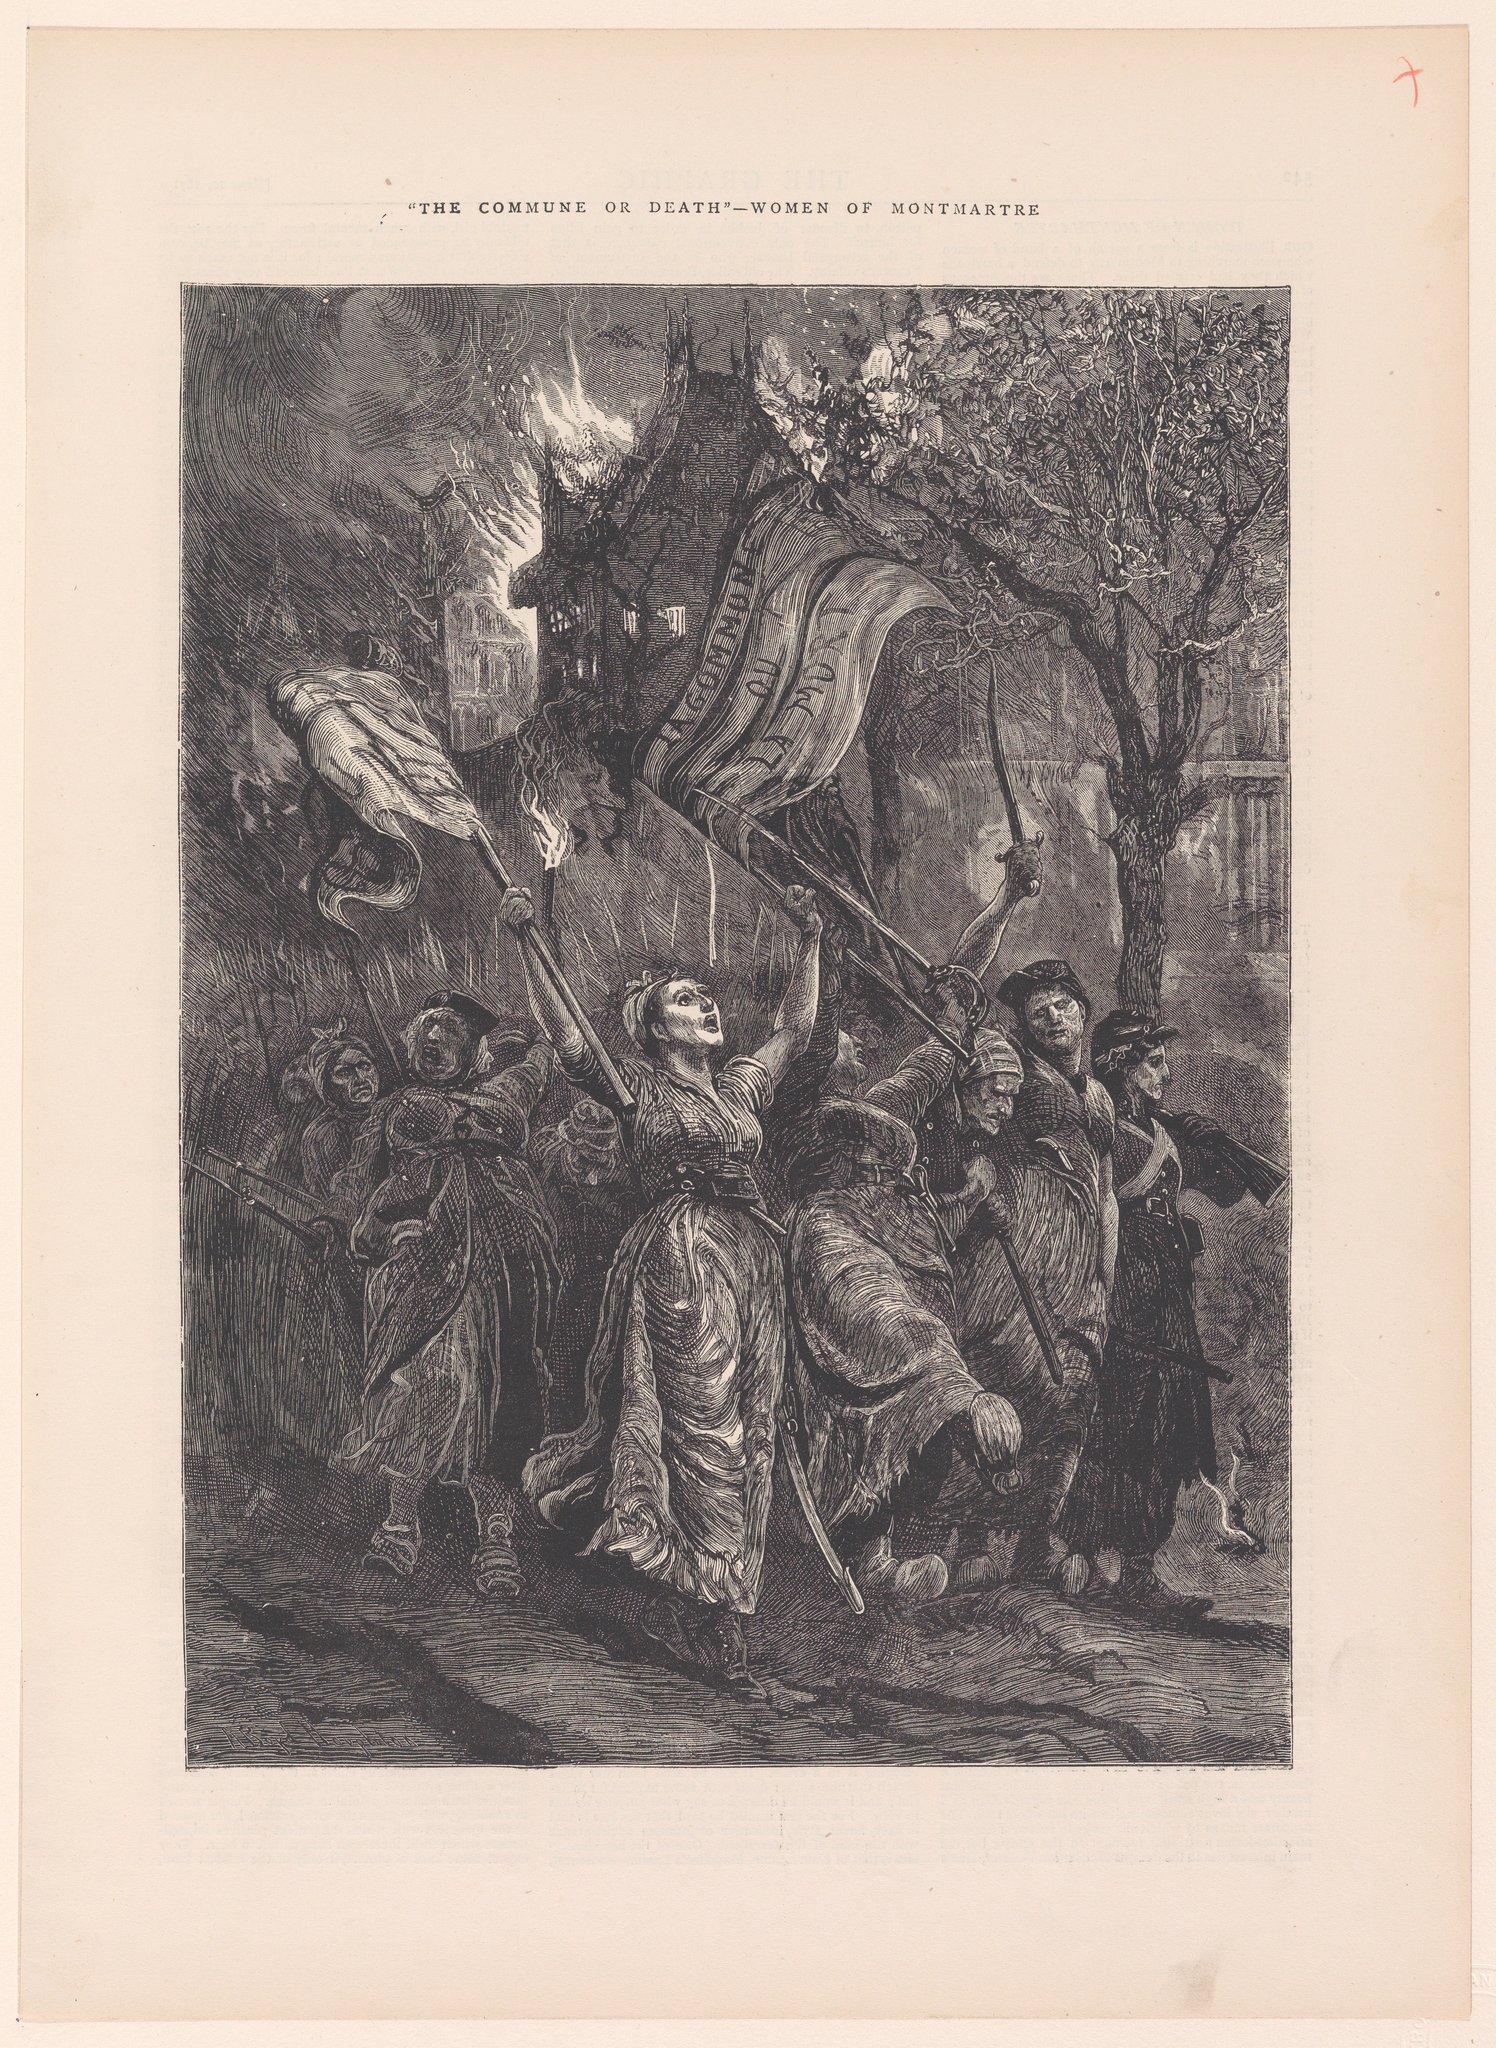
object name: print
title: Women of Montmartre, from "The Graphic," vol. 3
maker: arthur boyd houghton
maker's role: artist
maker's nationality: british, born india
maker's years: 1836-1875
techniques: engraving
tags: women,flags